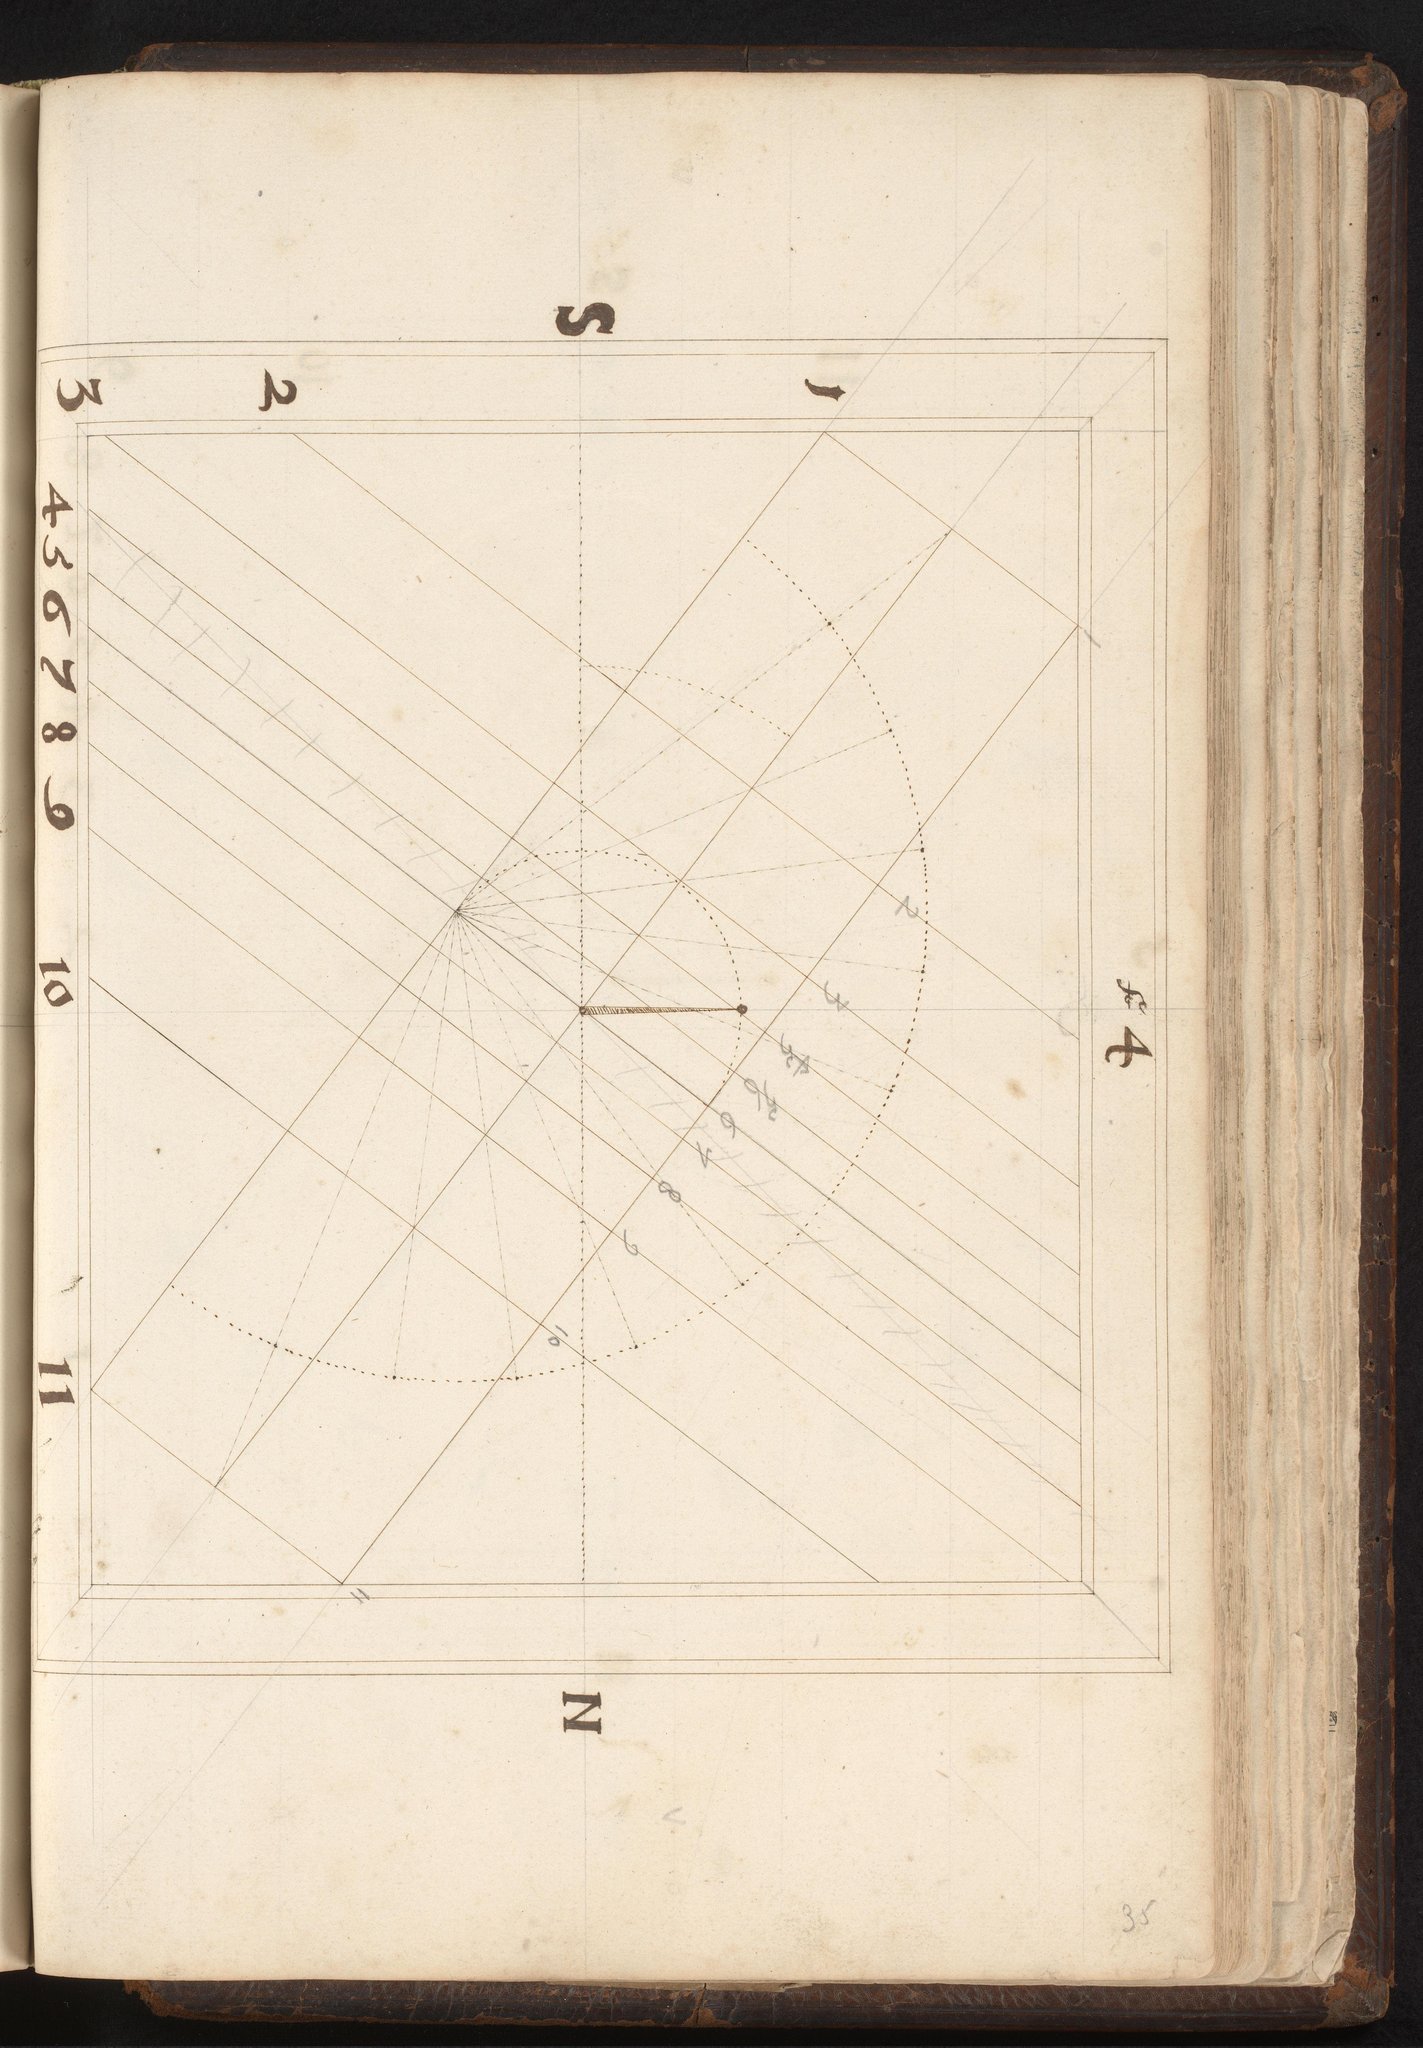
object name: drawing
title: Ontwerp voor een zonnewijzer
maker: Anonymous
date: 1650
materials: ink, paper, pencil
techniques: pen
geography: low countries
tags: sundial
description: Midden rechts genummerd: Fo 4. Tekening maakt deel uit van een album.